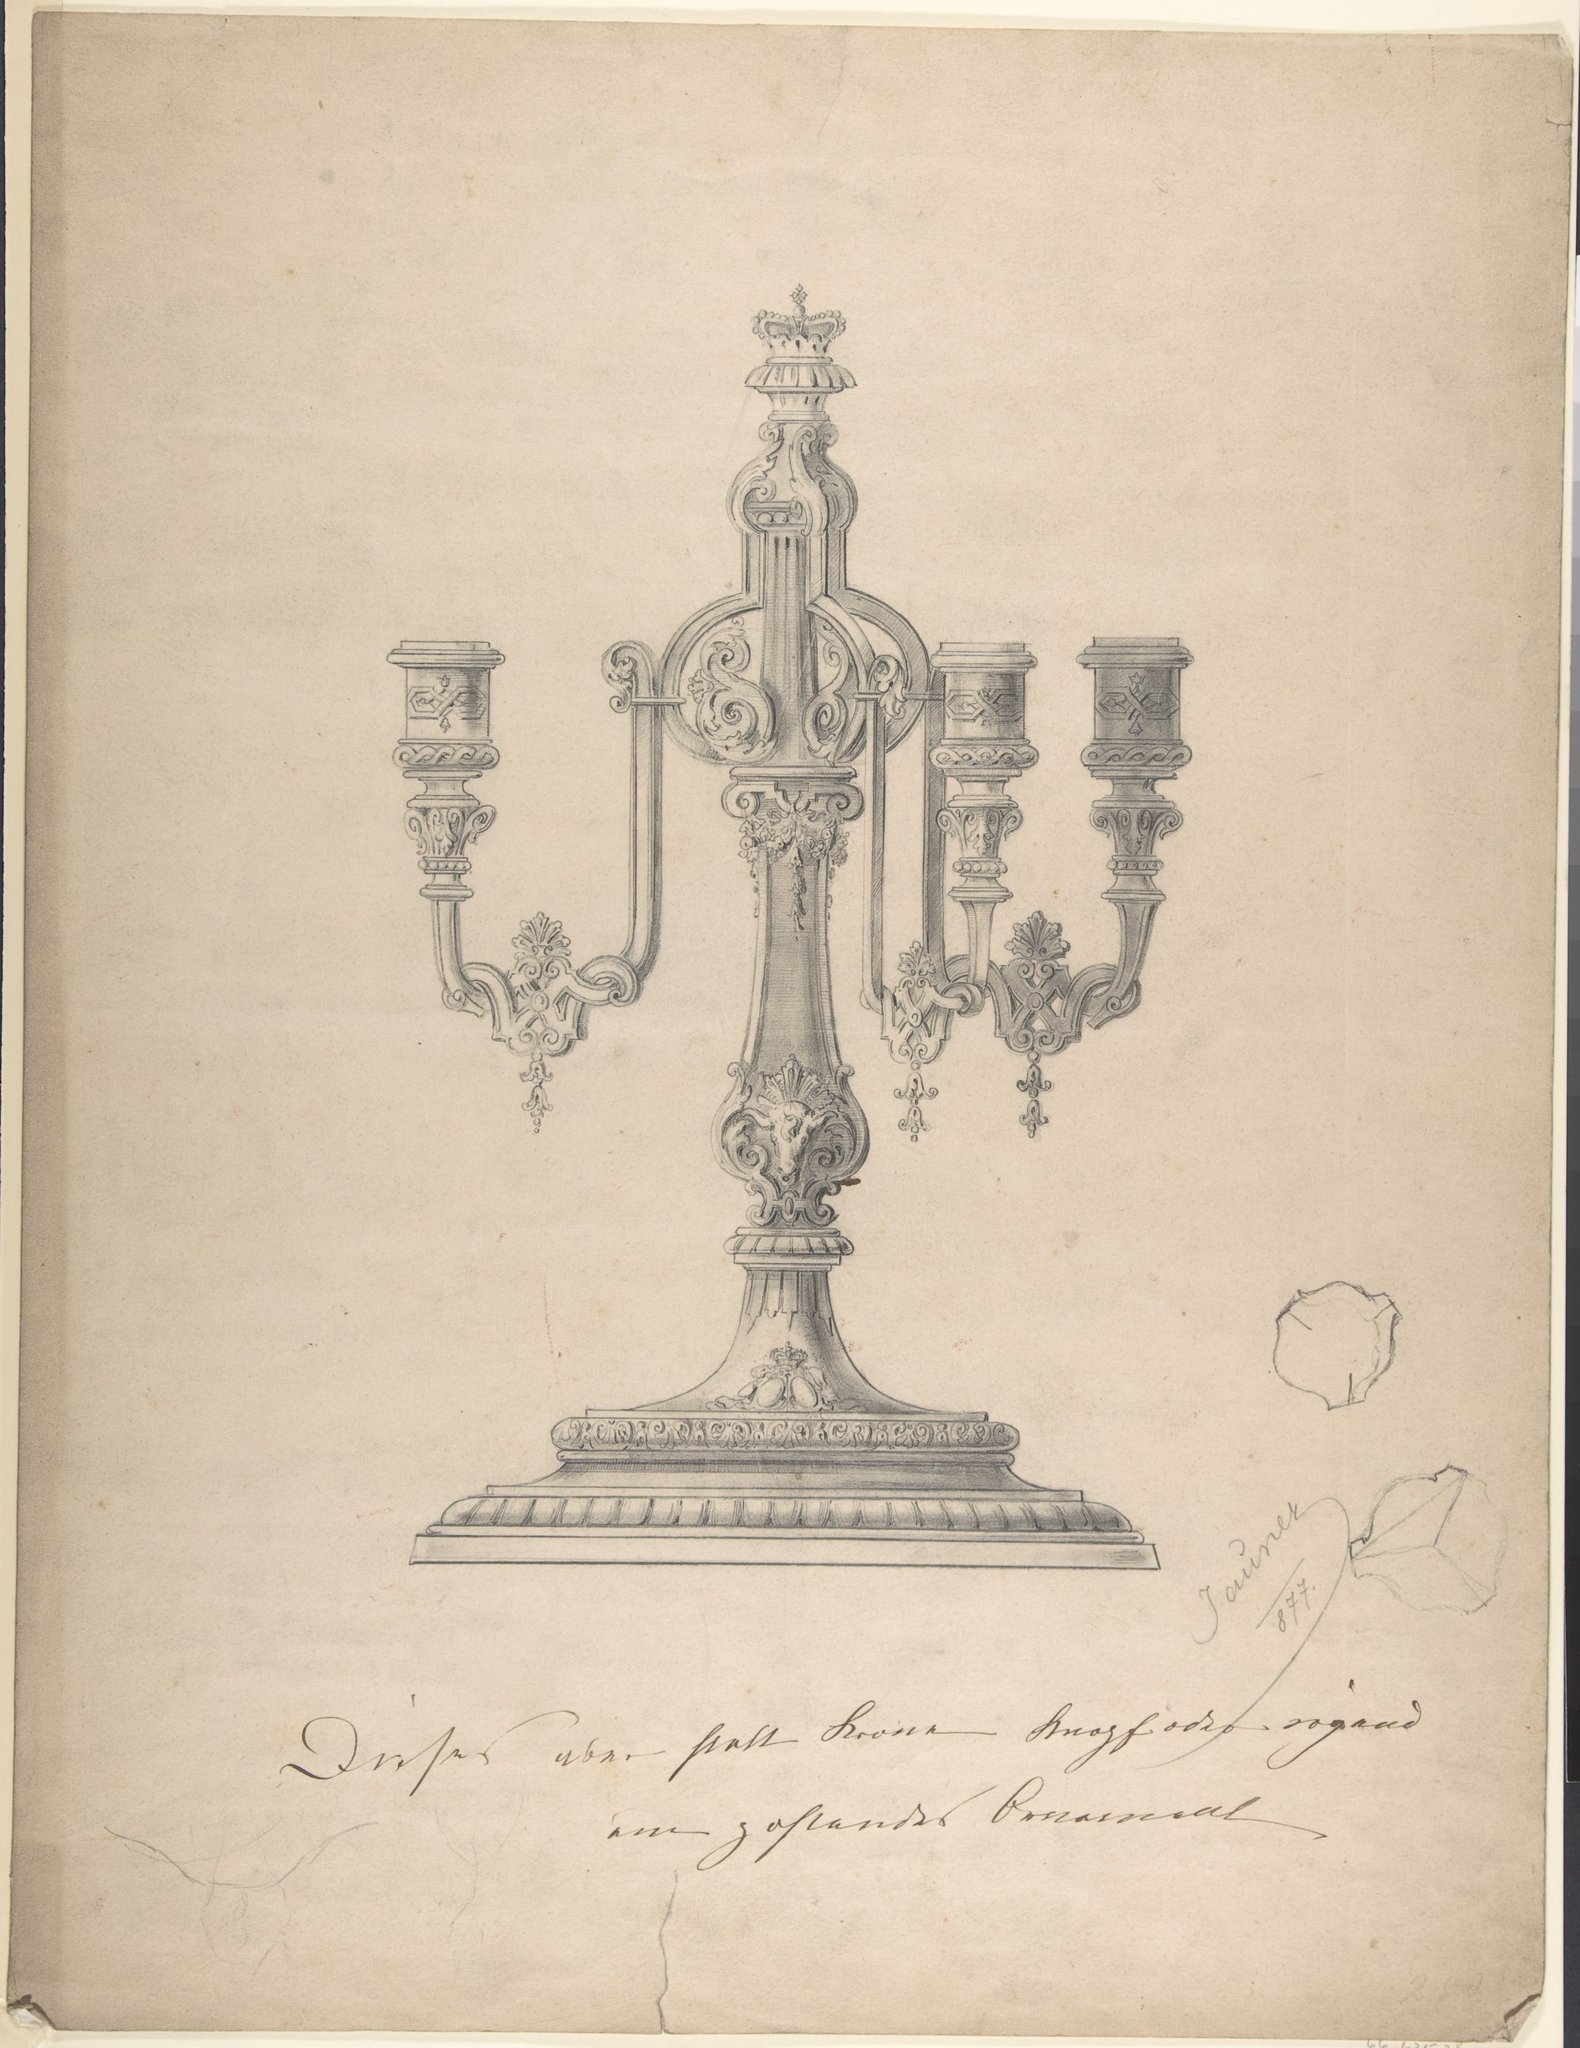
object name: drawing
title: Design for a Candelabra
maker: heinrich jauner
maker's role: artist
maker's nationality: austrian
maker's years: 1842-1912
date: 1877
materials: graphite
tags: candelabra